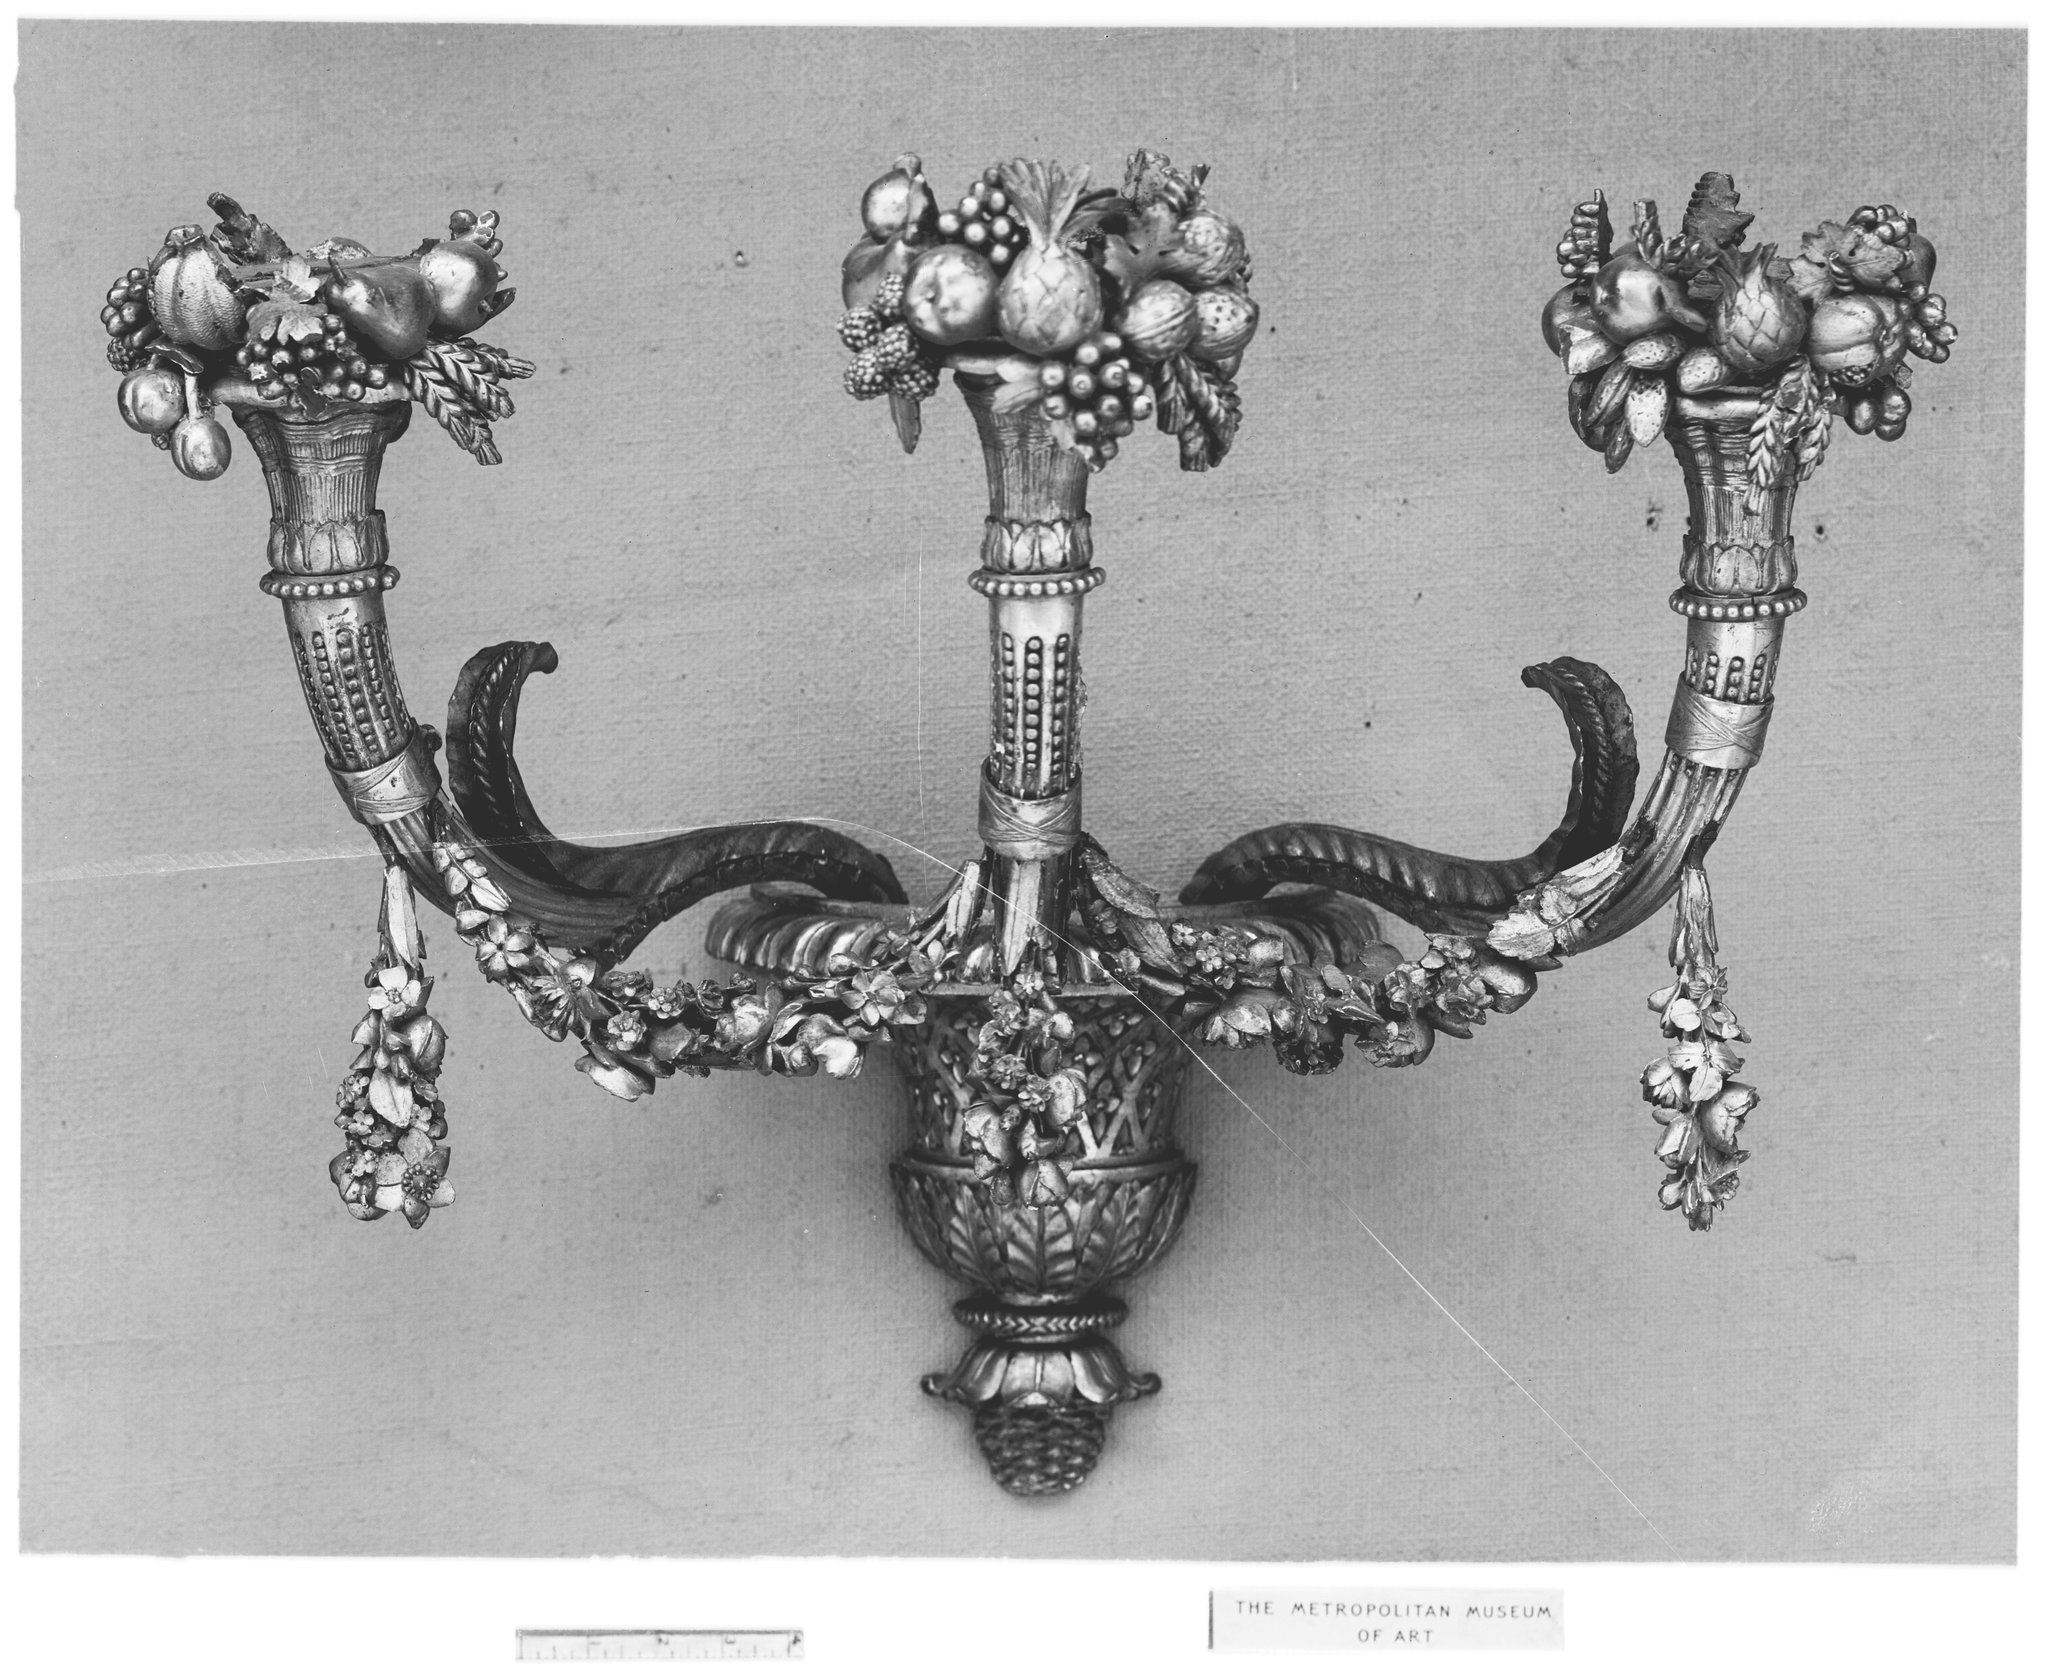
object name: wall light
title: Wall light (candelabre appliqué)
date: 1701-1800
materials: wood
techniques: carving, gilding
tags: cornucopia